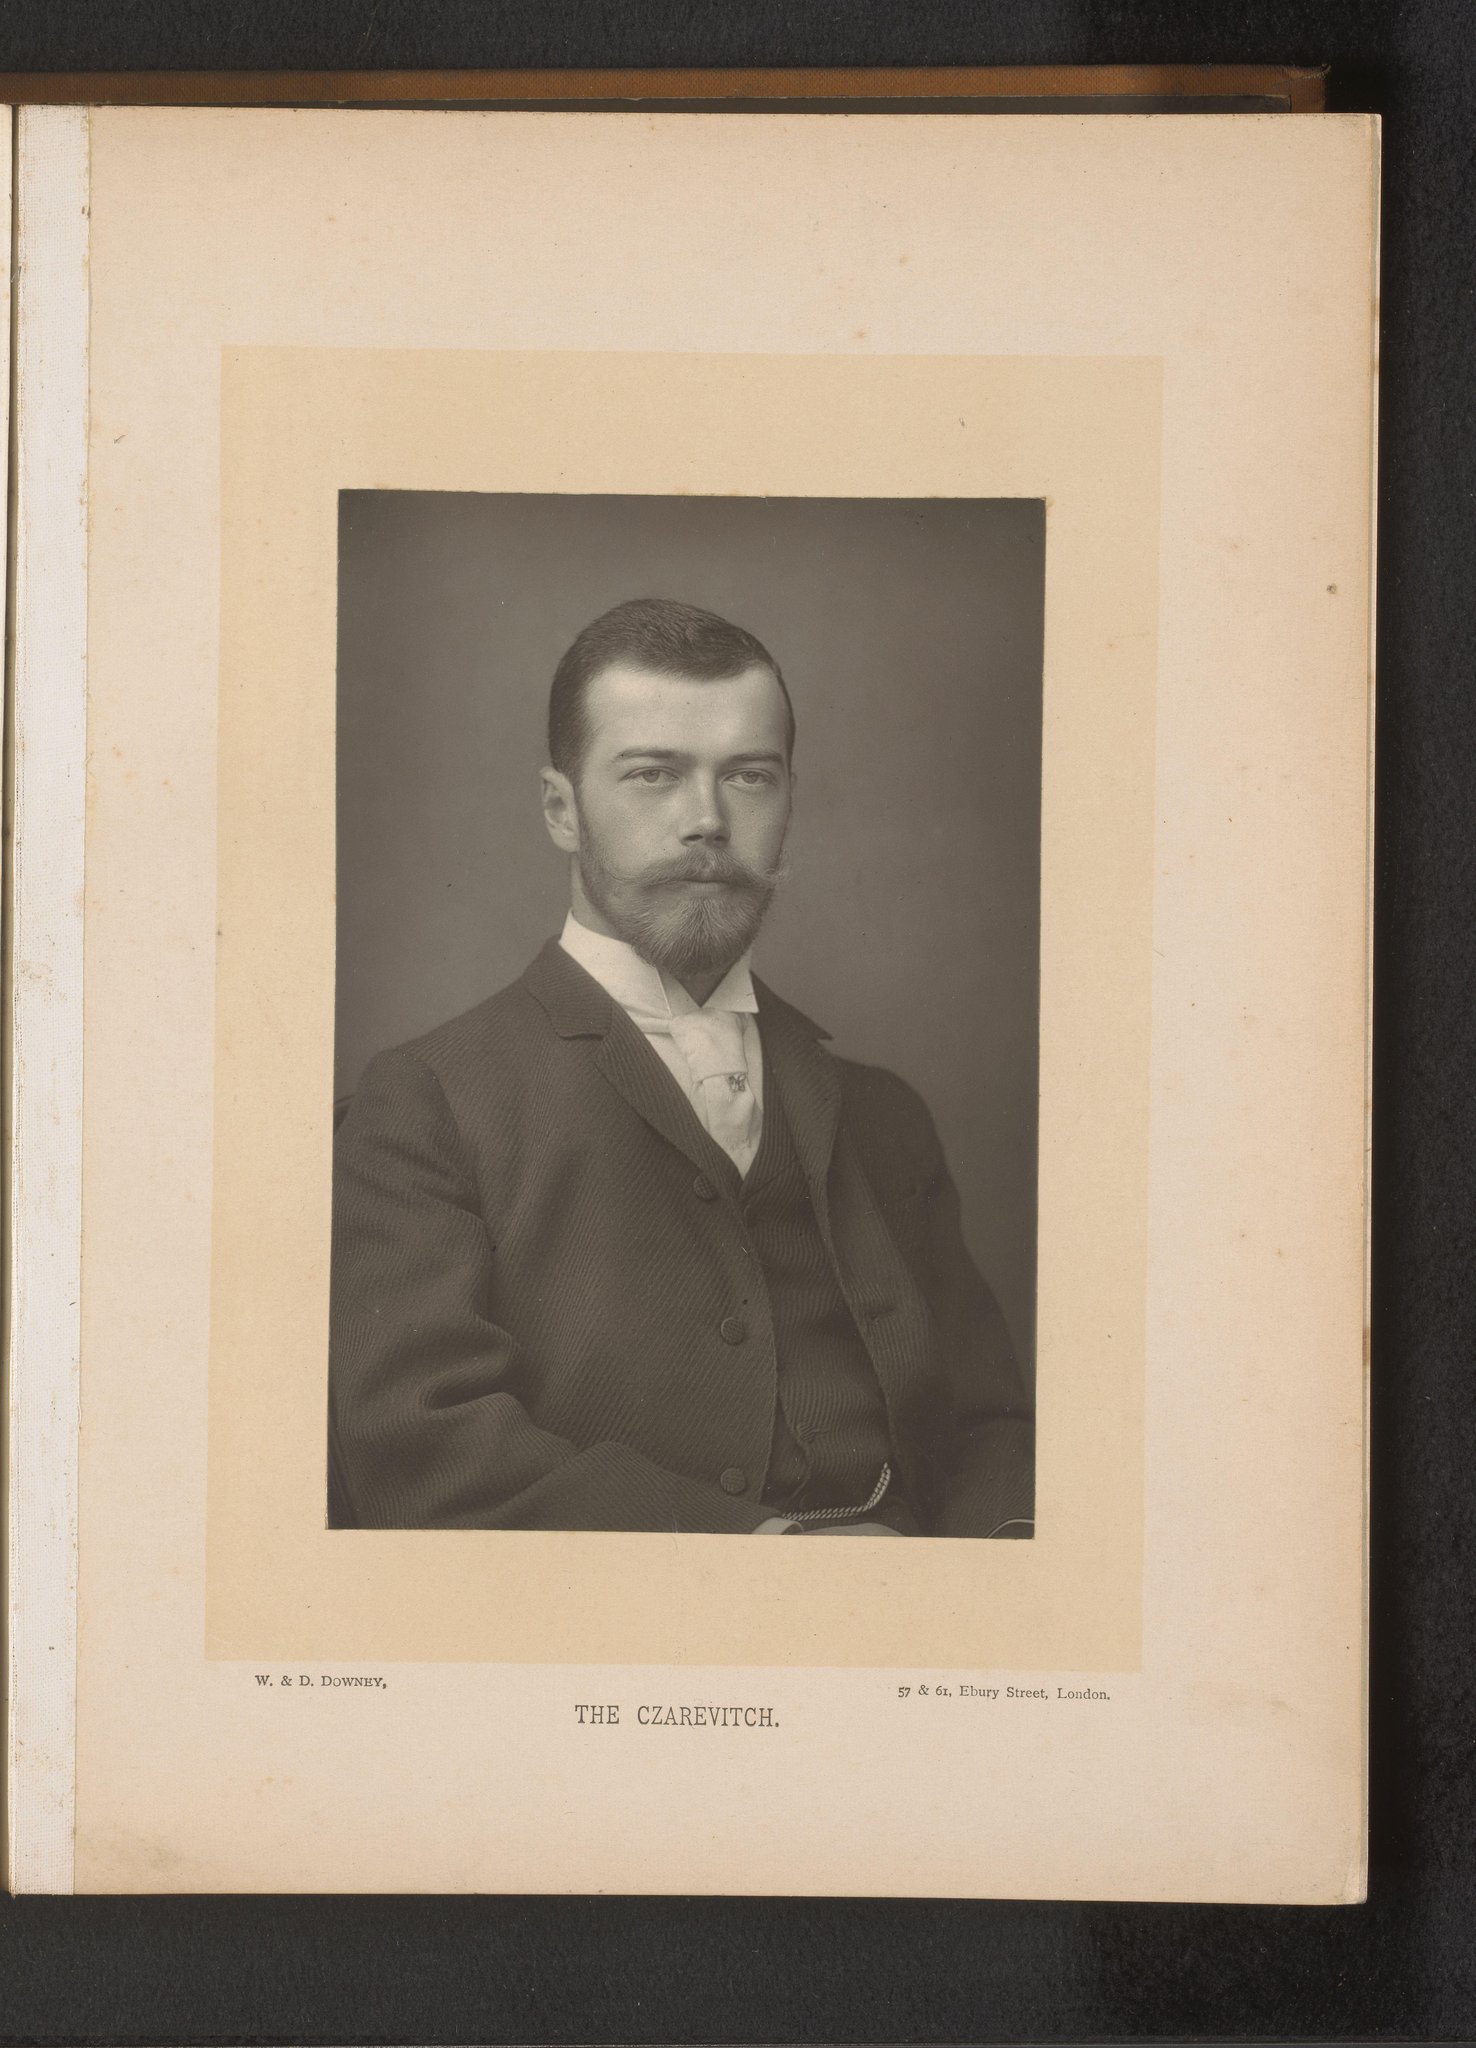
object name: page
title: The Czarevitch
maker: Anonymous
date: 1884-1894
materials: paper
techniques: woodburytype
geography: london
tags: ruler, sovereign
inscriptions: inscription: ‘57 & 61, Elbury Street, London.’